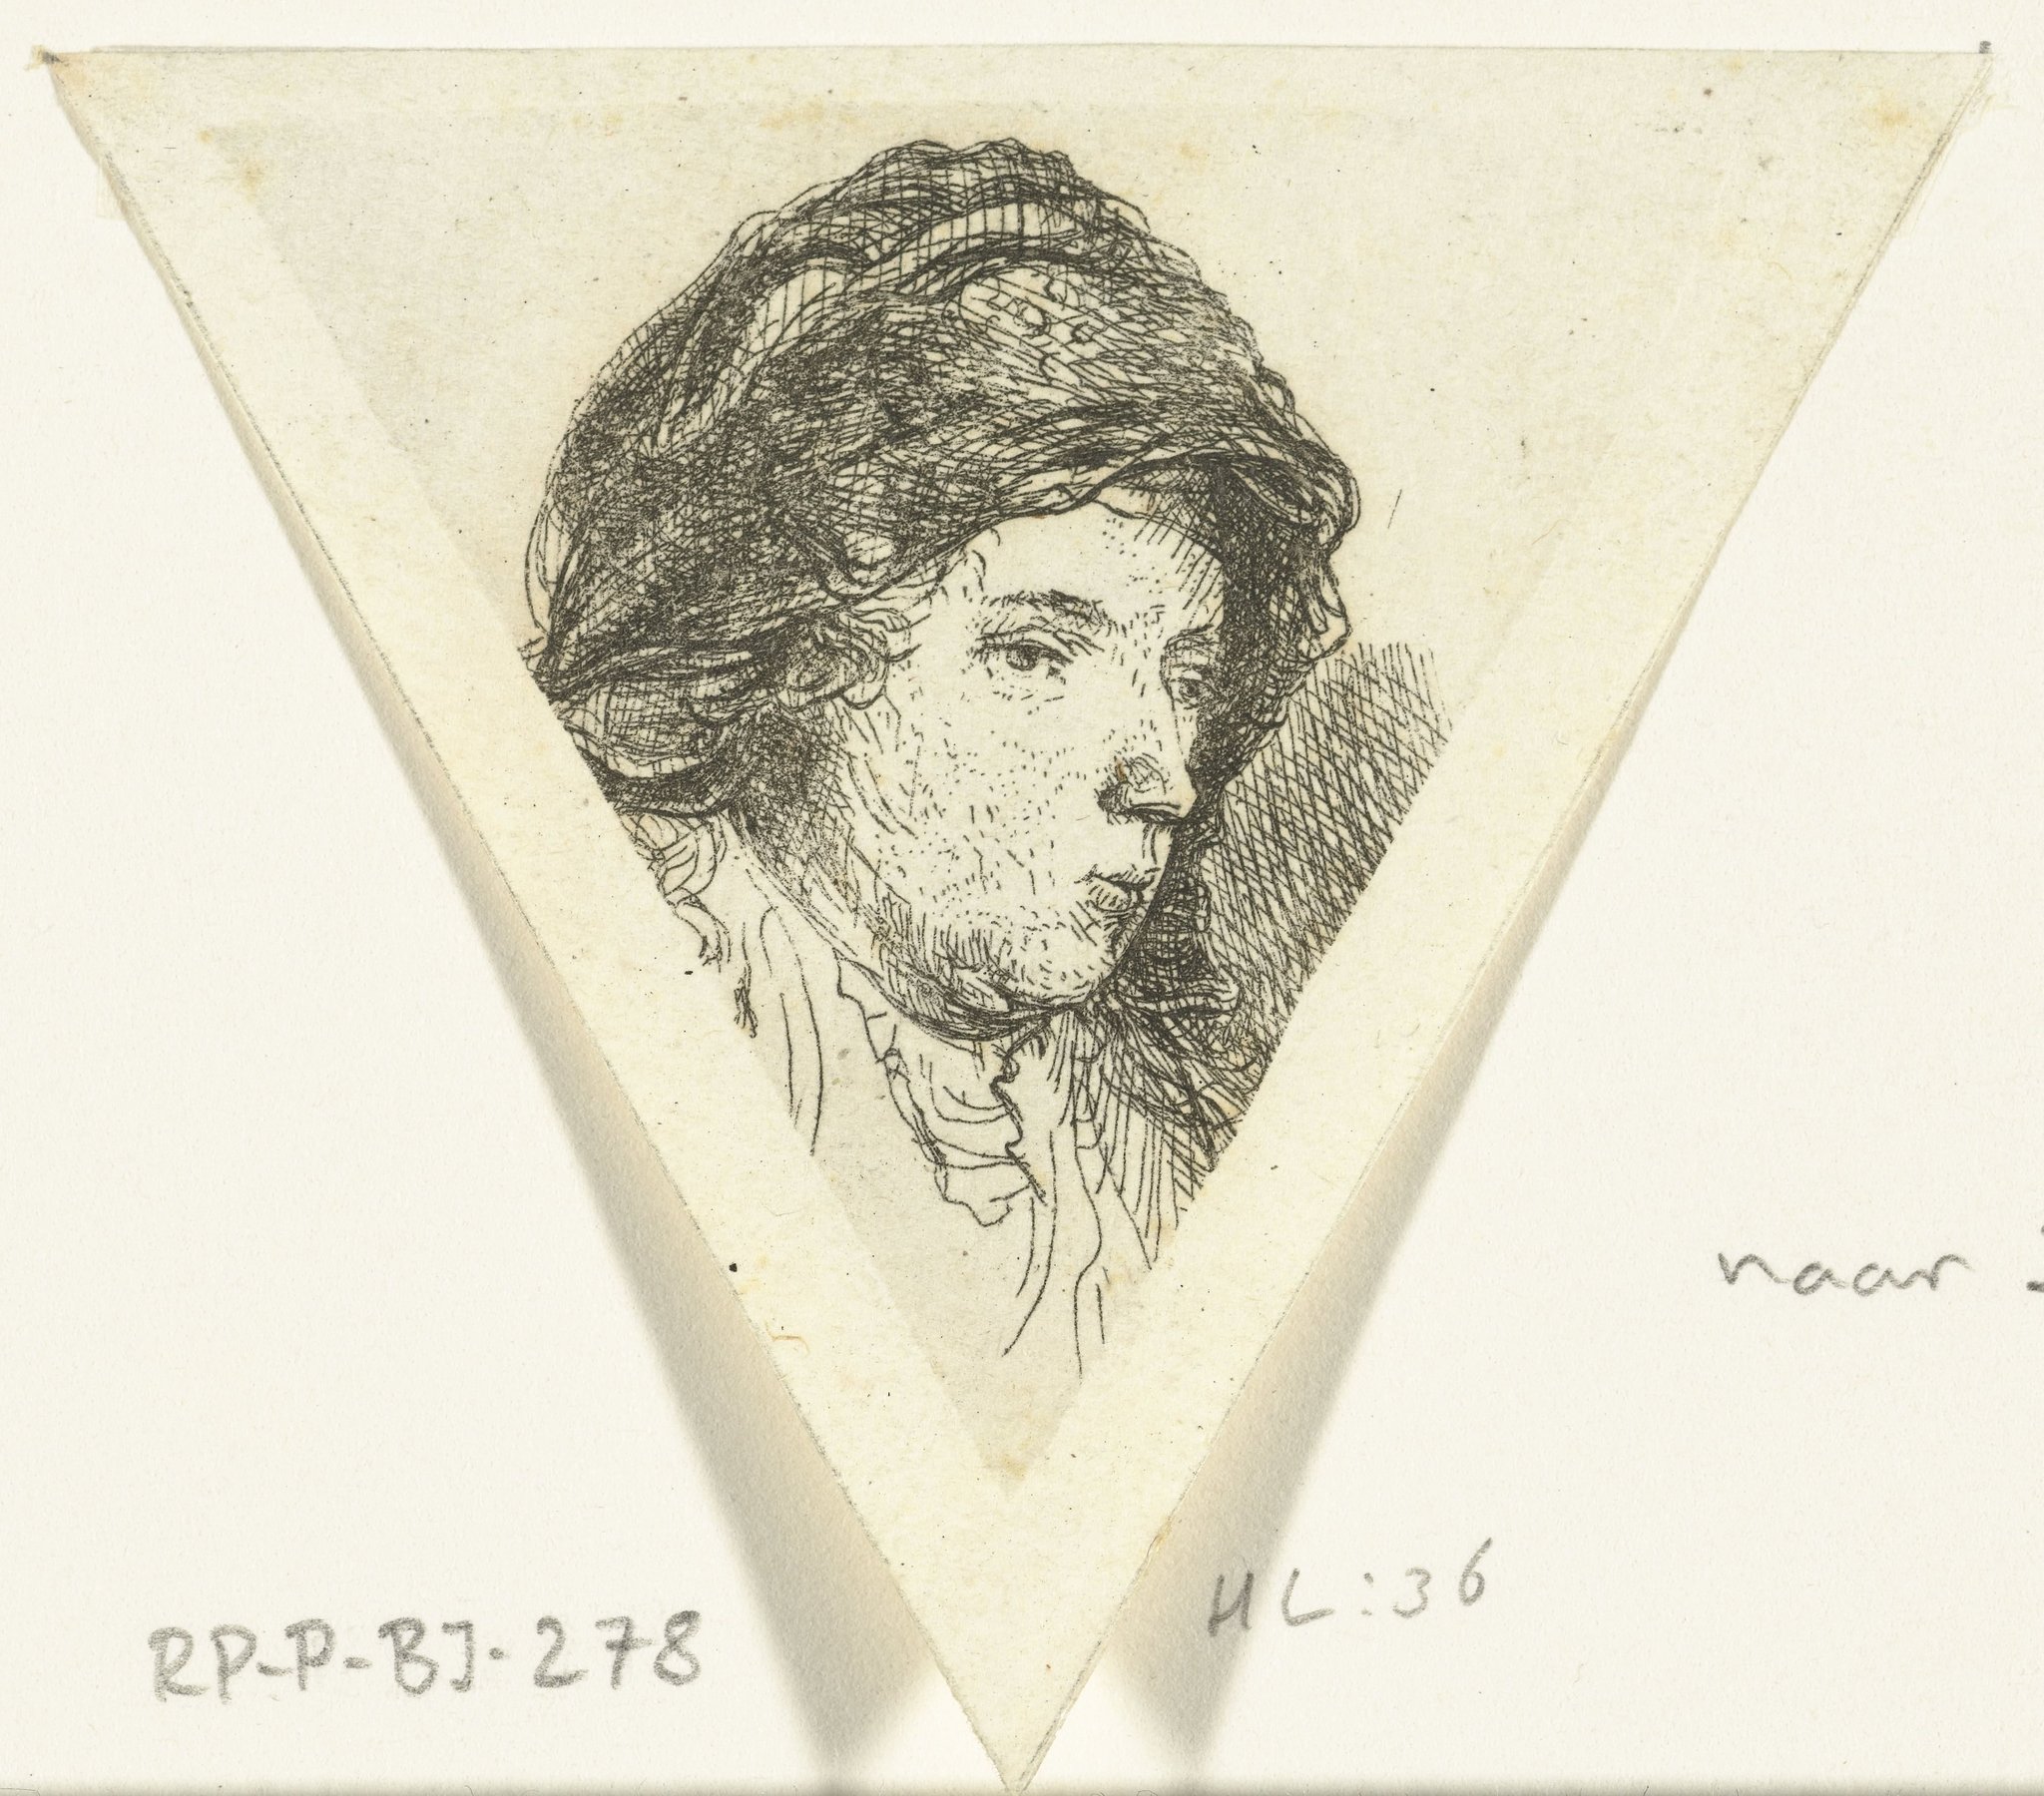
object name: print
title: Portretbuste van een vrouw met doek om haar hoofd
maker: ernst willem jan bagelaar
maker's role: draughtsman, print maker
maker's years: 1775-1837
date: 1798-1837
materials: paper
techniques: etching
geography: netherlands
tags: adolescent, young woman, maiden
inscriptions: collector's mark: Lugt 2228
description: kopie in spiegelbeeld naar Rembrandt: Bartsch 368